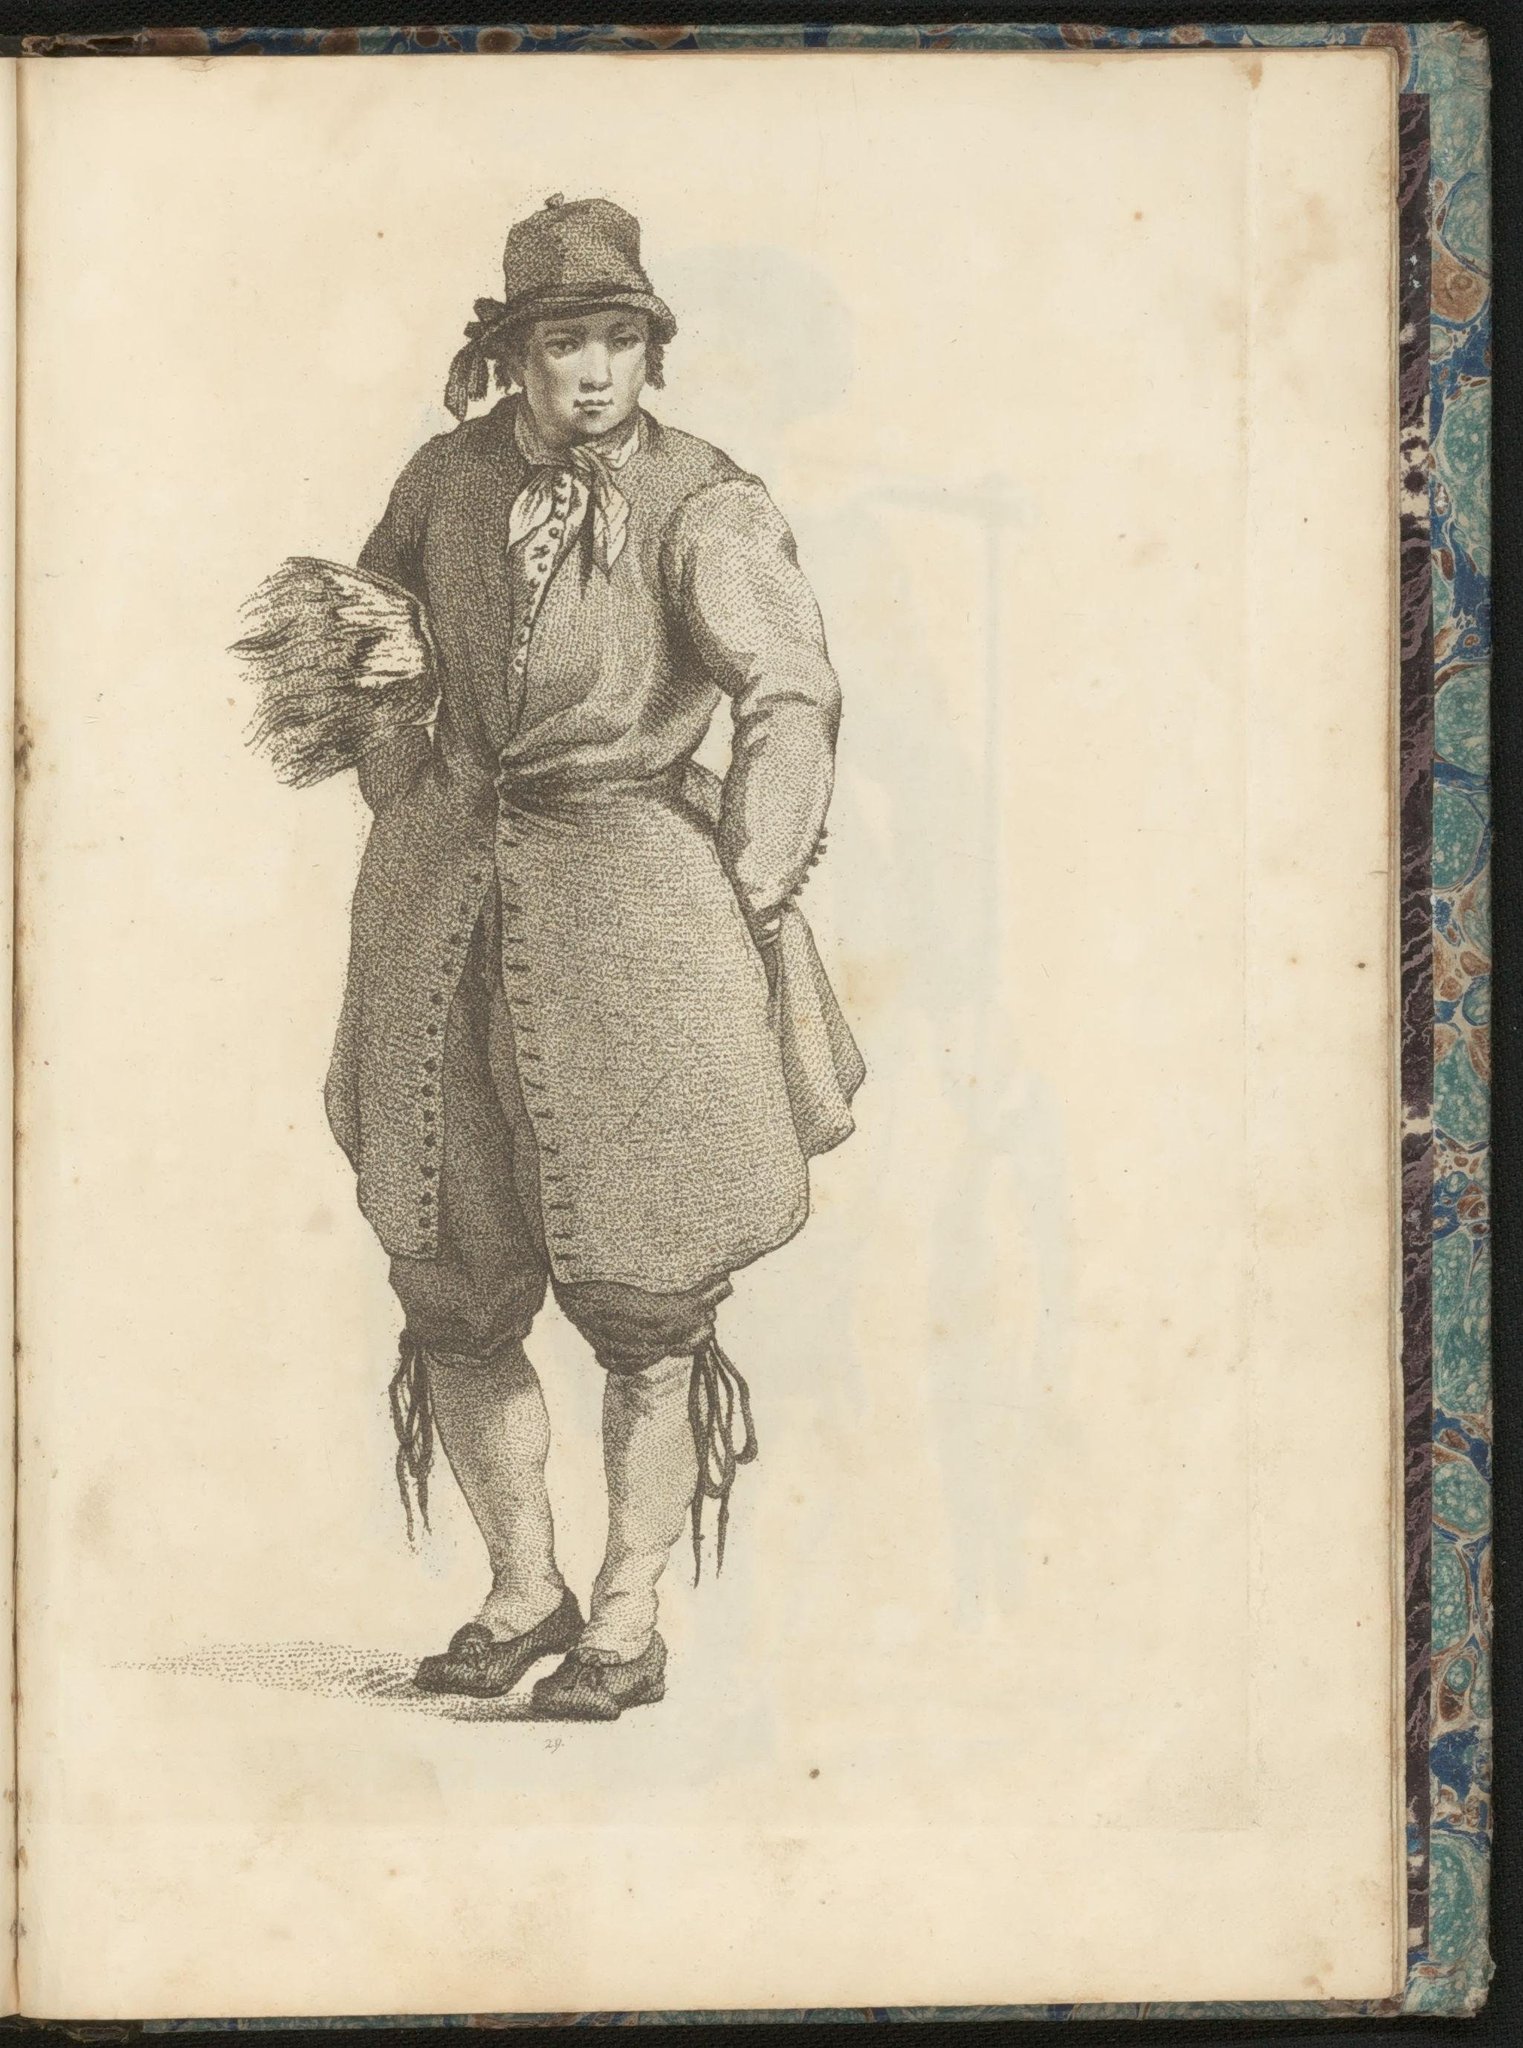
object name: print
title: Boer met korenschoof onder de arm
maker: mathias de sallieth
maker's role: print maker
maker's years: 1749-1791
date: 1772-1791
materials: paper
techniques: aquatint, printmaking, etching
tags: farmers, sheaf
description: De prent verscheen vanaf 1818 tevens als onderdeel van een 33-delige reeks prenten door Mathias de Sallieth, samengebonden in: Perkois, Jacobus, Prins, Johannes Huibert. Verzameling van verschillende gekleede mans- en vrouwenstanden, ter oefening van jonge schilders en liefhebbers. Rotterdam: Johannes Immerzeel, 1818. Alle verso-bladen uit dit prentalbum zijn blanco.